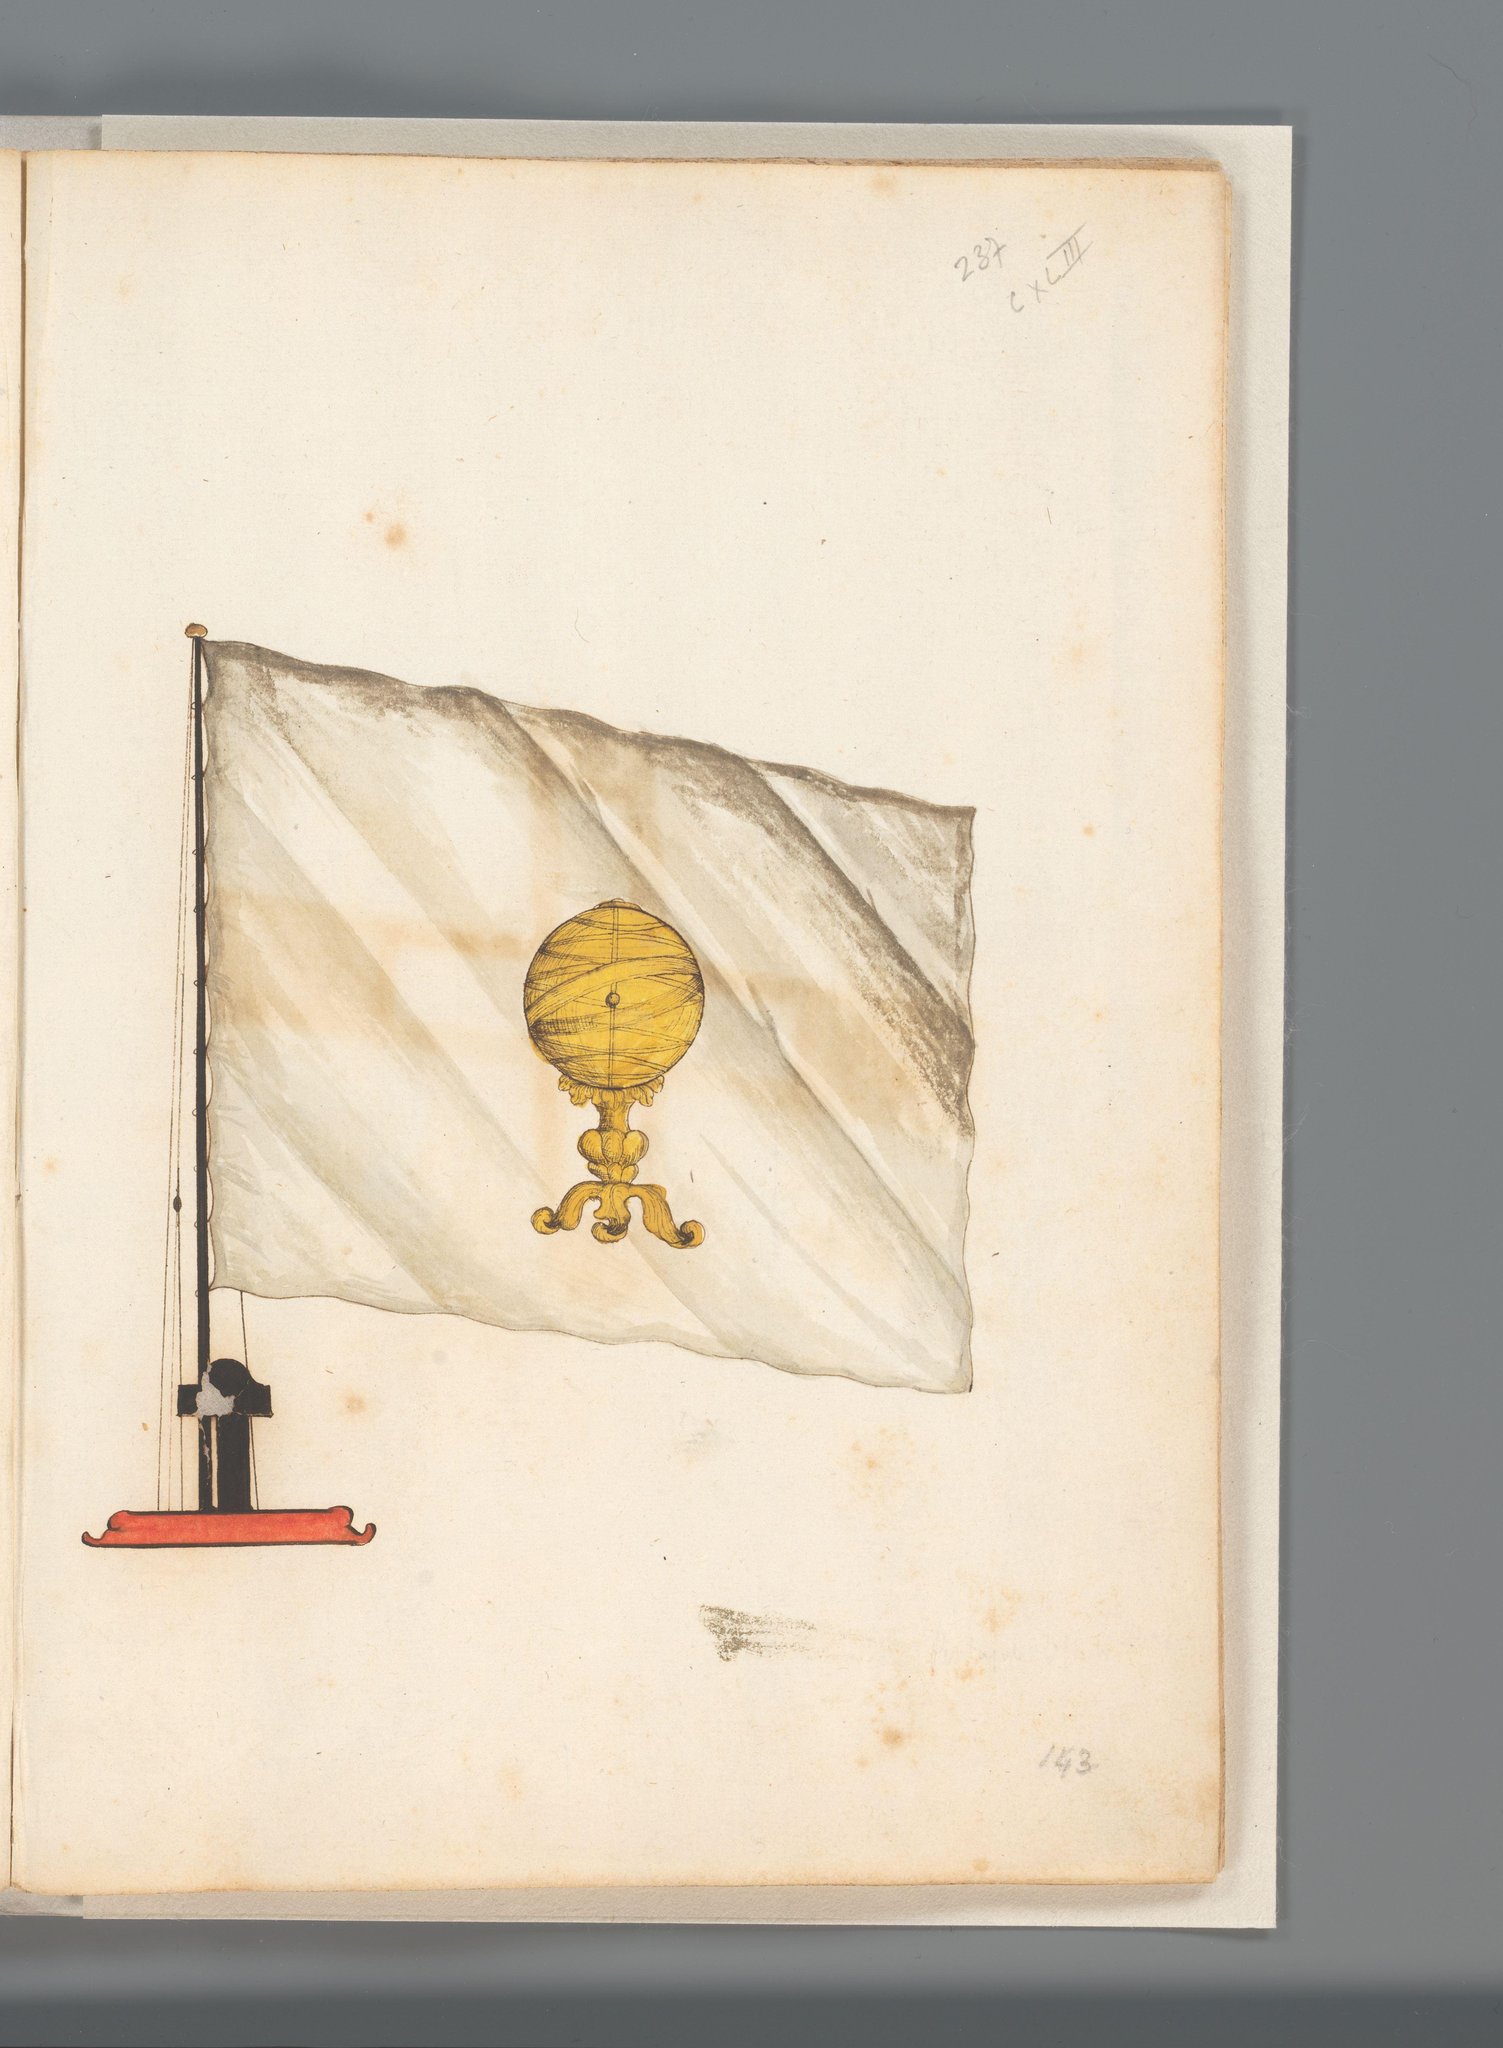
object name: drawing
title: Vlag van Brazilië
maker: Anonymous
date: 1667-1670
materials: ink, paper, watercolor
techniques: brush, pen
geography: france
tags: flag, colours (as symbol of the state, etc.), brasil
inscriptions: number: ‘237 / CXLIII / 143’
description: Vlag van Brazilië. Witte vlag met een gouden armillarium staande op een voet. Vlag op vlaggensteng en mastvoet. Afgebeeld op folio 72r. Onderdeel van een vlaggenboek met vlaggen uit Europa, Noord-Afrika, Nabije en Verre Oosten.